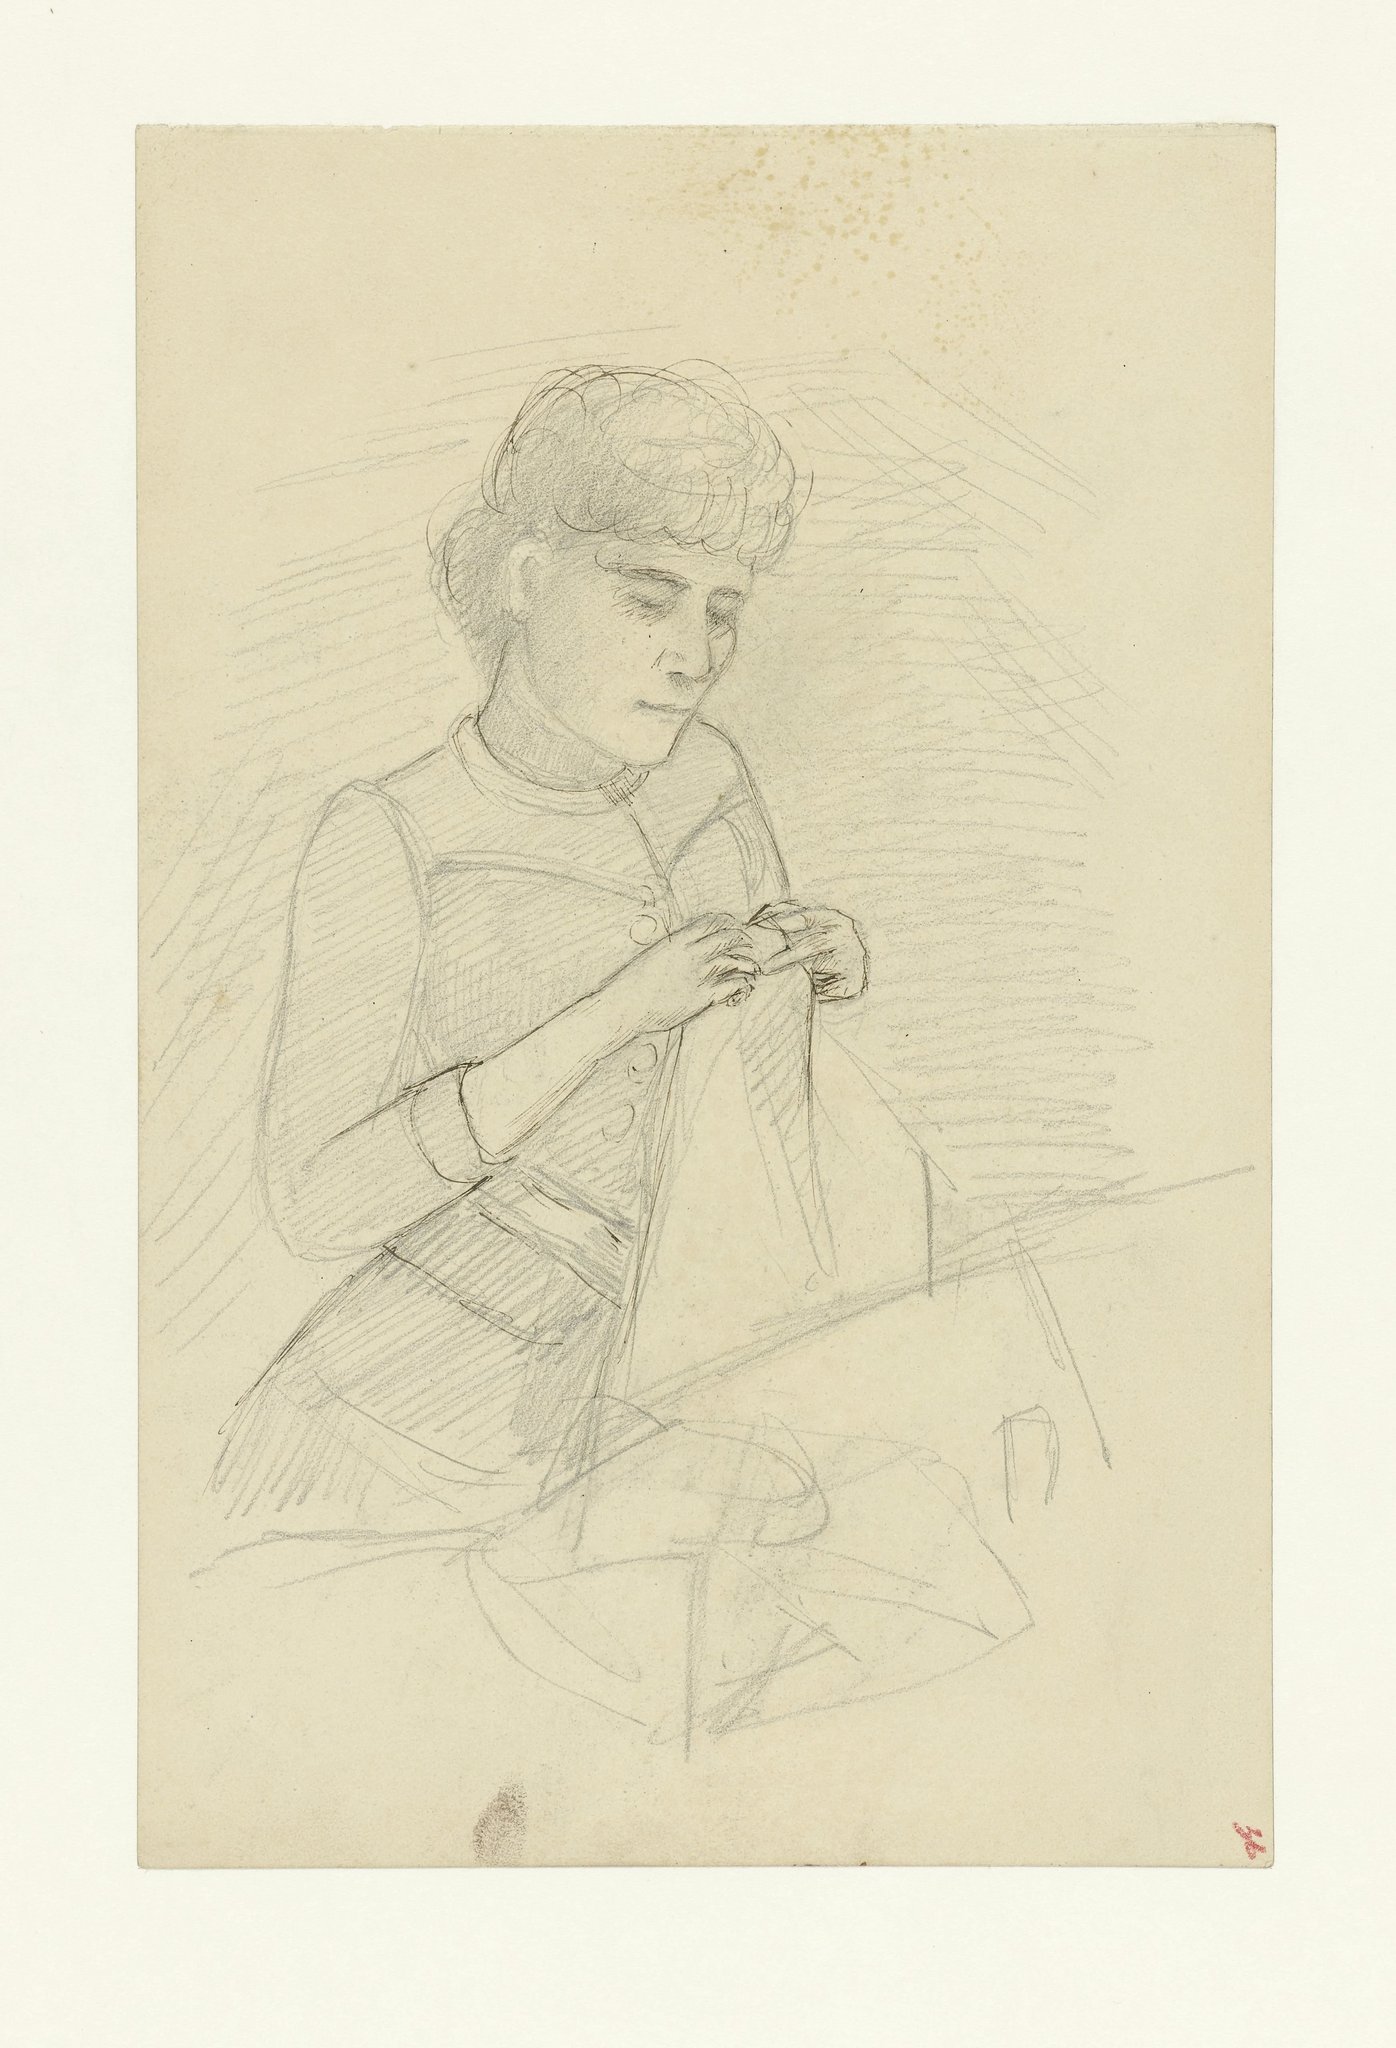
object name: drawing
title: Handwerkende vrouw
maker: jozef israëls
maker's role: draughtsman, painter, print maker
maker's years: 1824-1911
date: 1834-1911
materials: ink, paper, pencil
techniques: pen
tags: (other forms of) needlework, e.g.: crocheting, knitting, embroidering